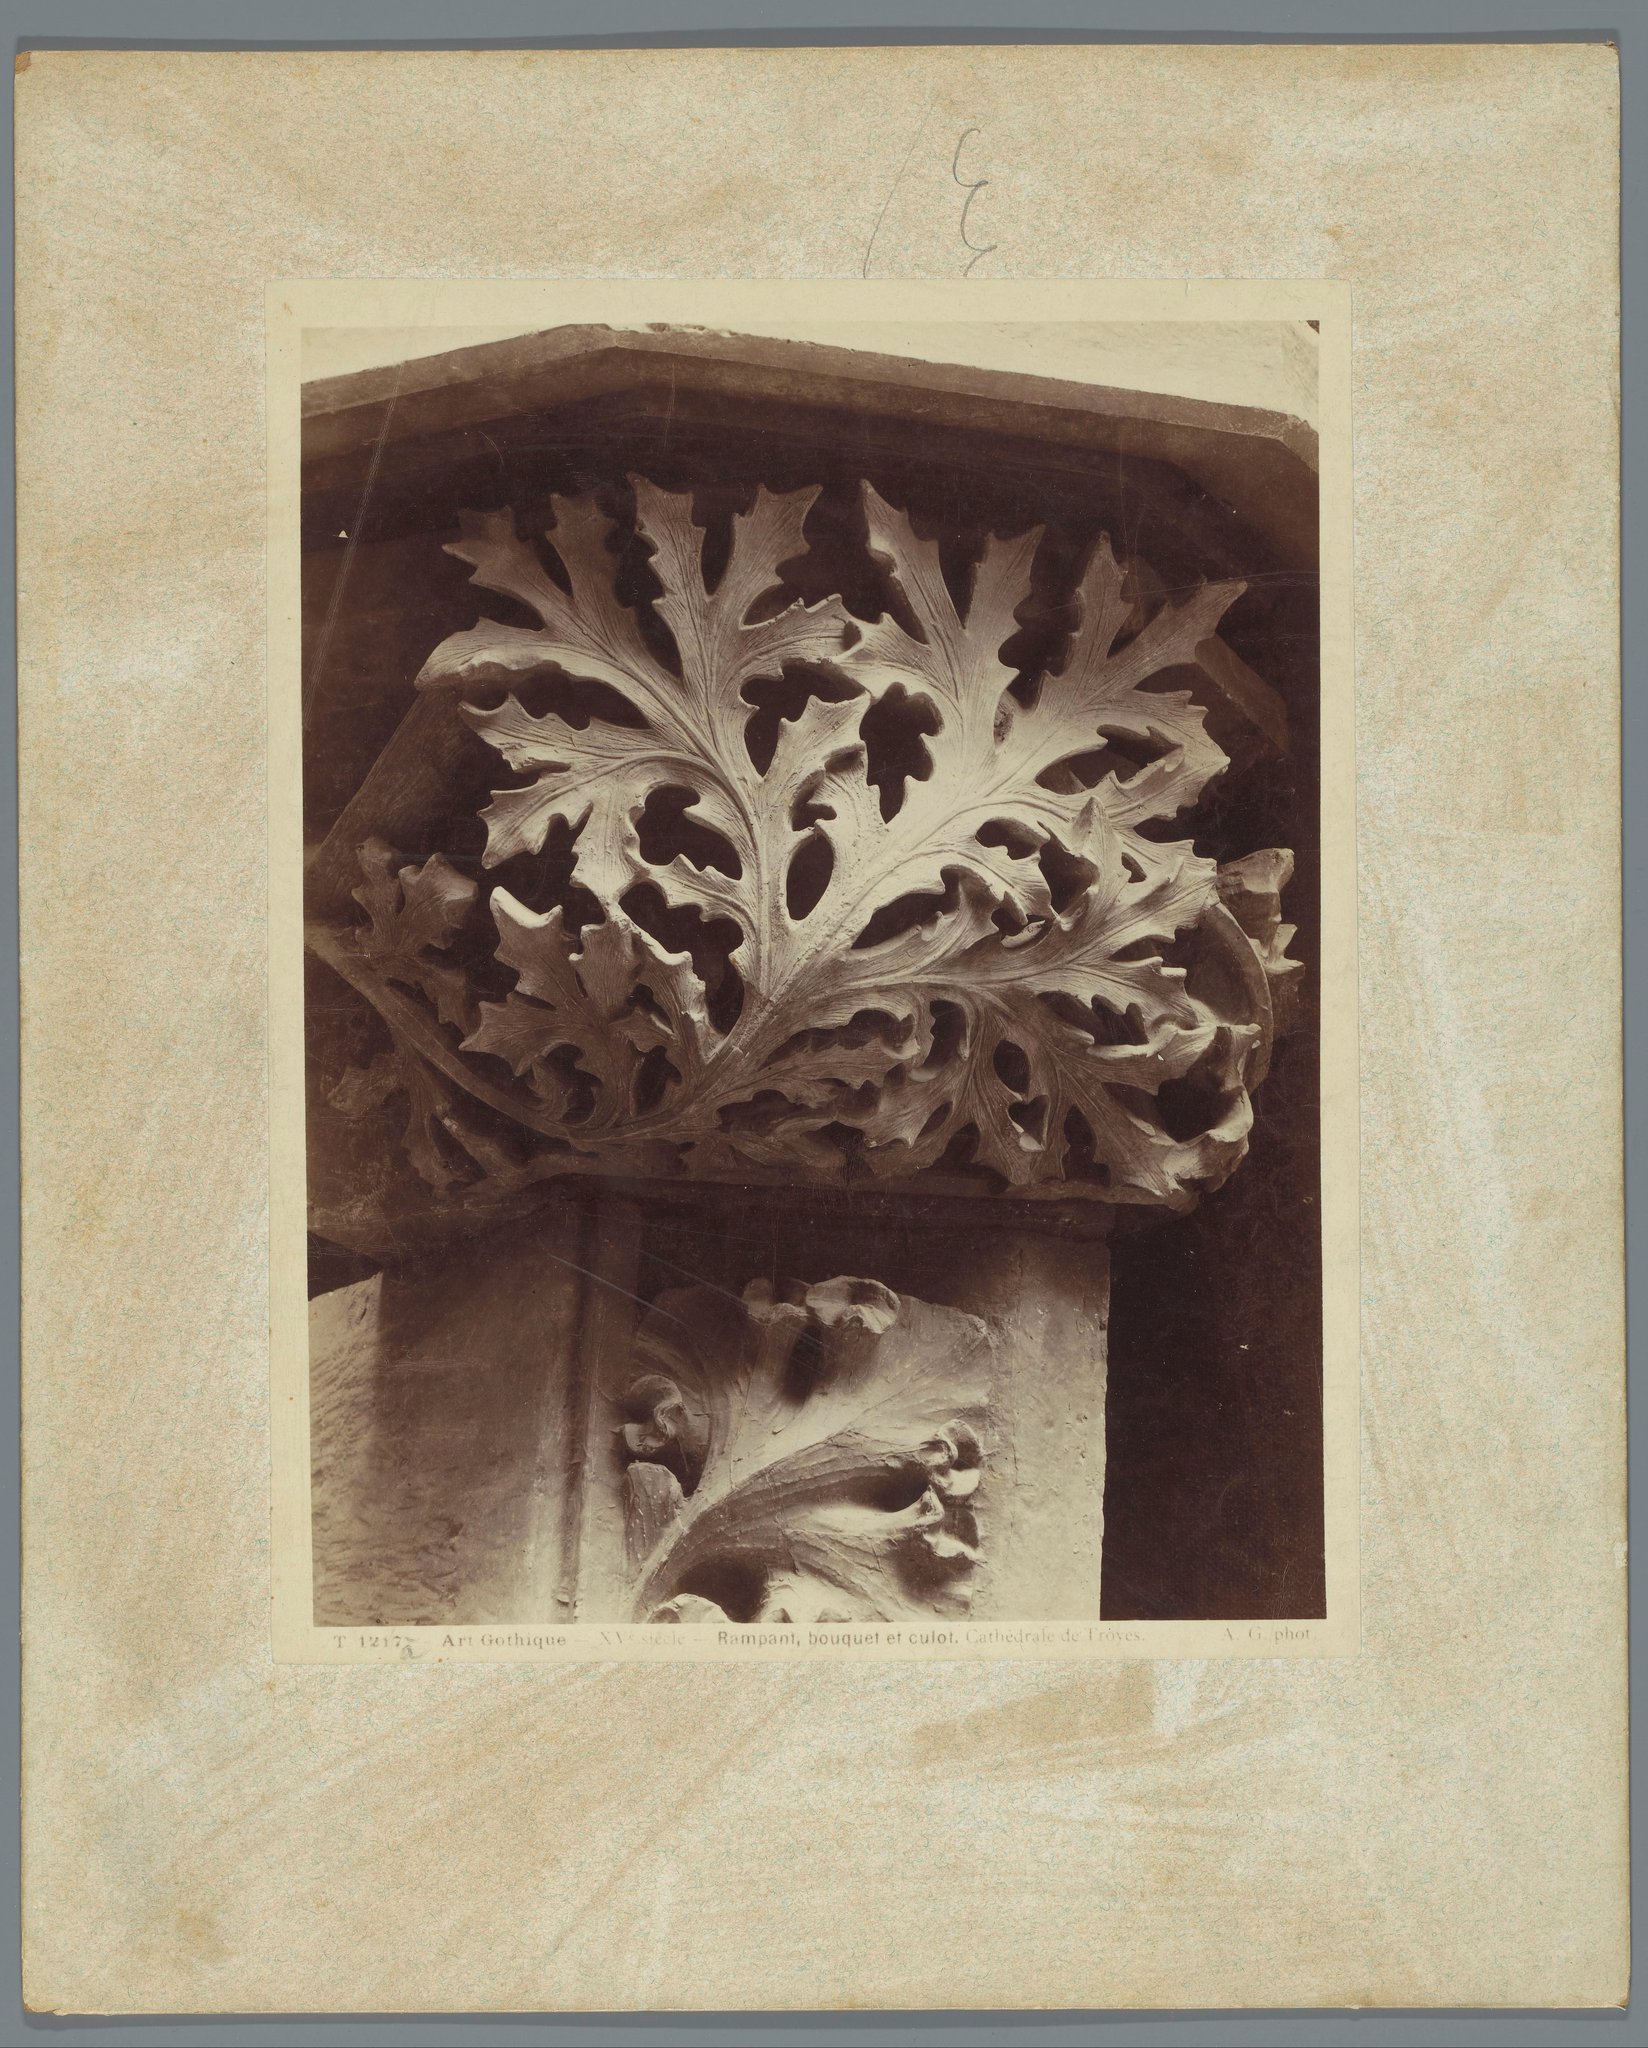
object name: photograph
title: Art Gothique - XVe siècle - Rampant, bouquet et culot. Cathédrale de Troyes.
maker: adolphe giraudon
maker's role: publisher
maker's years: 1849-1929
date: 1875-1900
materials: cardboard, photographic support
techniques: albumen print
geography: france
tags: foliage ~ ornament, capital (~ column, pillar)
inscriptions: number: ‘T 1217’, collector's mark: ‘RIJKS-NORMAALSCHOOL voor TEEKENONDERWIJZERS AMSTERDAM’